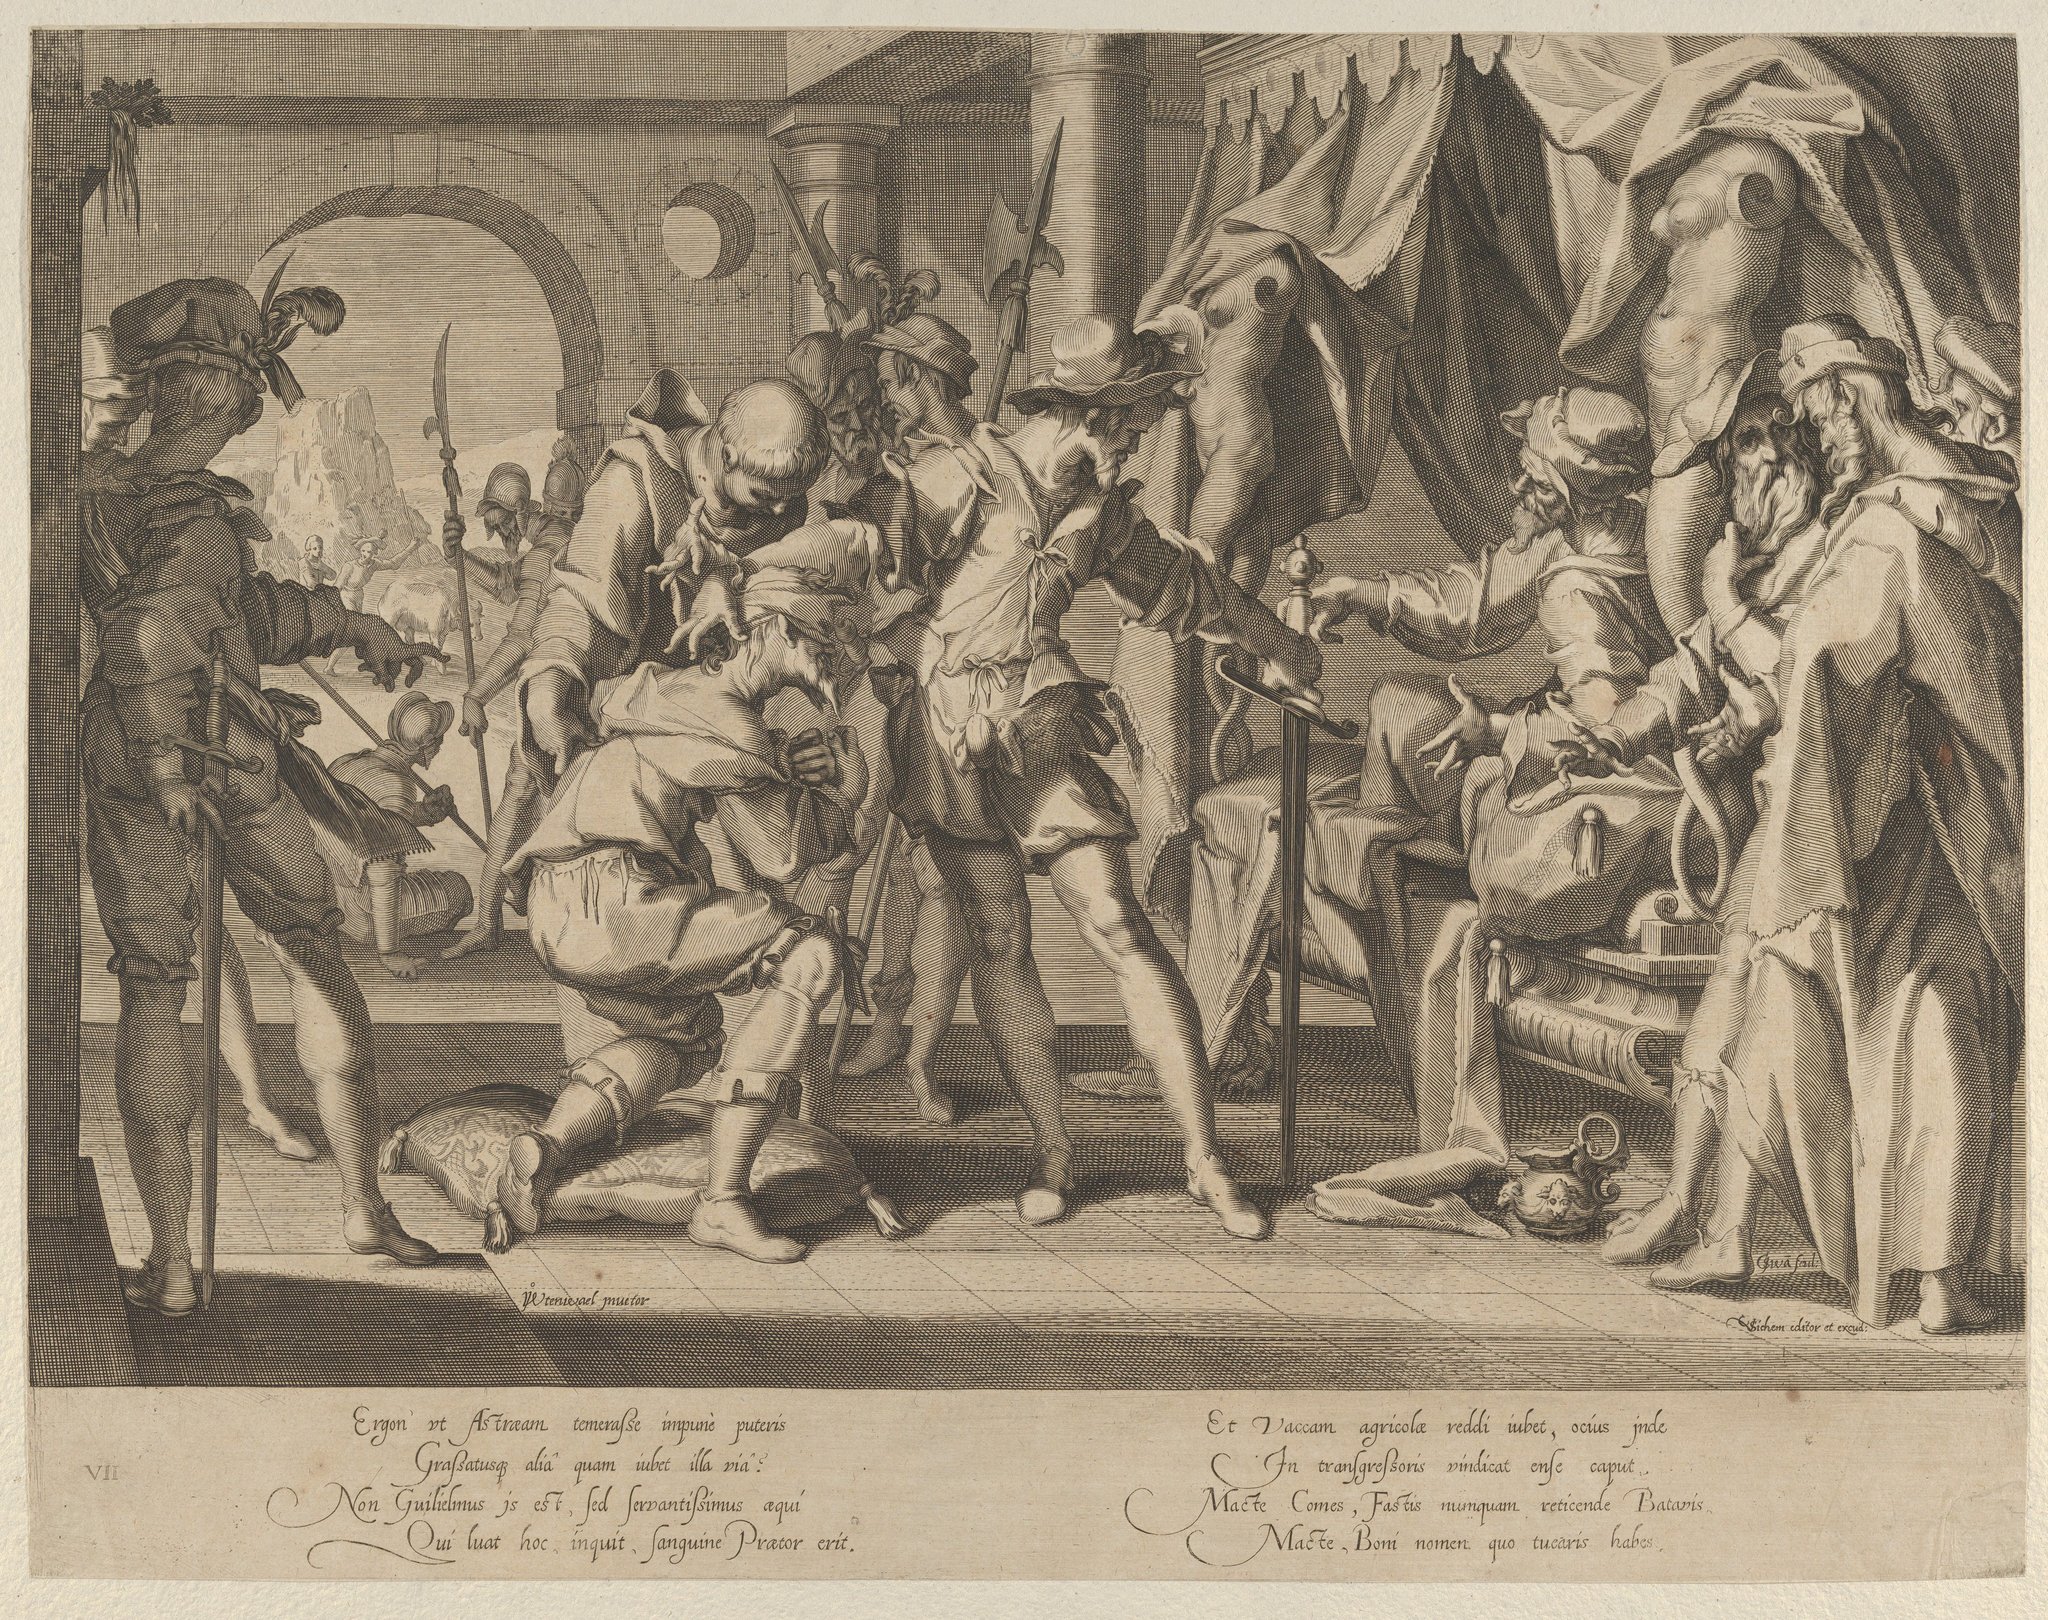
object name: print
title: Count William III of Holland Permitting the Beheading of his Bailiff, plate 7 from "Thronus Justitiae, tredecim pulcherrimus tabulis..."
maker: willem van swanenburg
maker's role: artist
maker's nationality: netherlandish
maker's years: 1581-1612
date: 1605-1606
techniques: engraving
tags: swords,kings,suffering,men